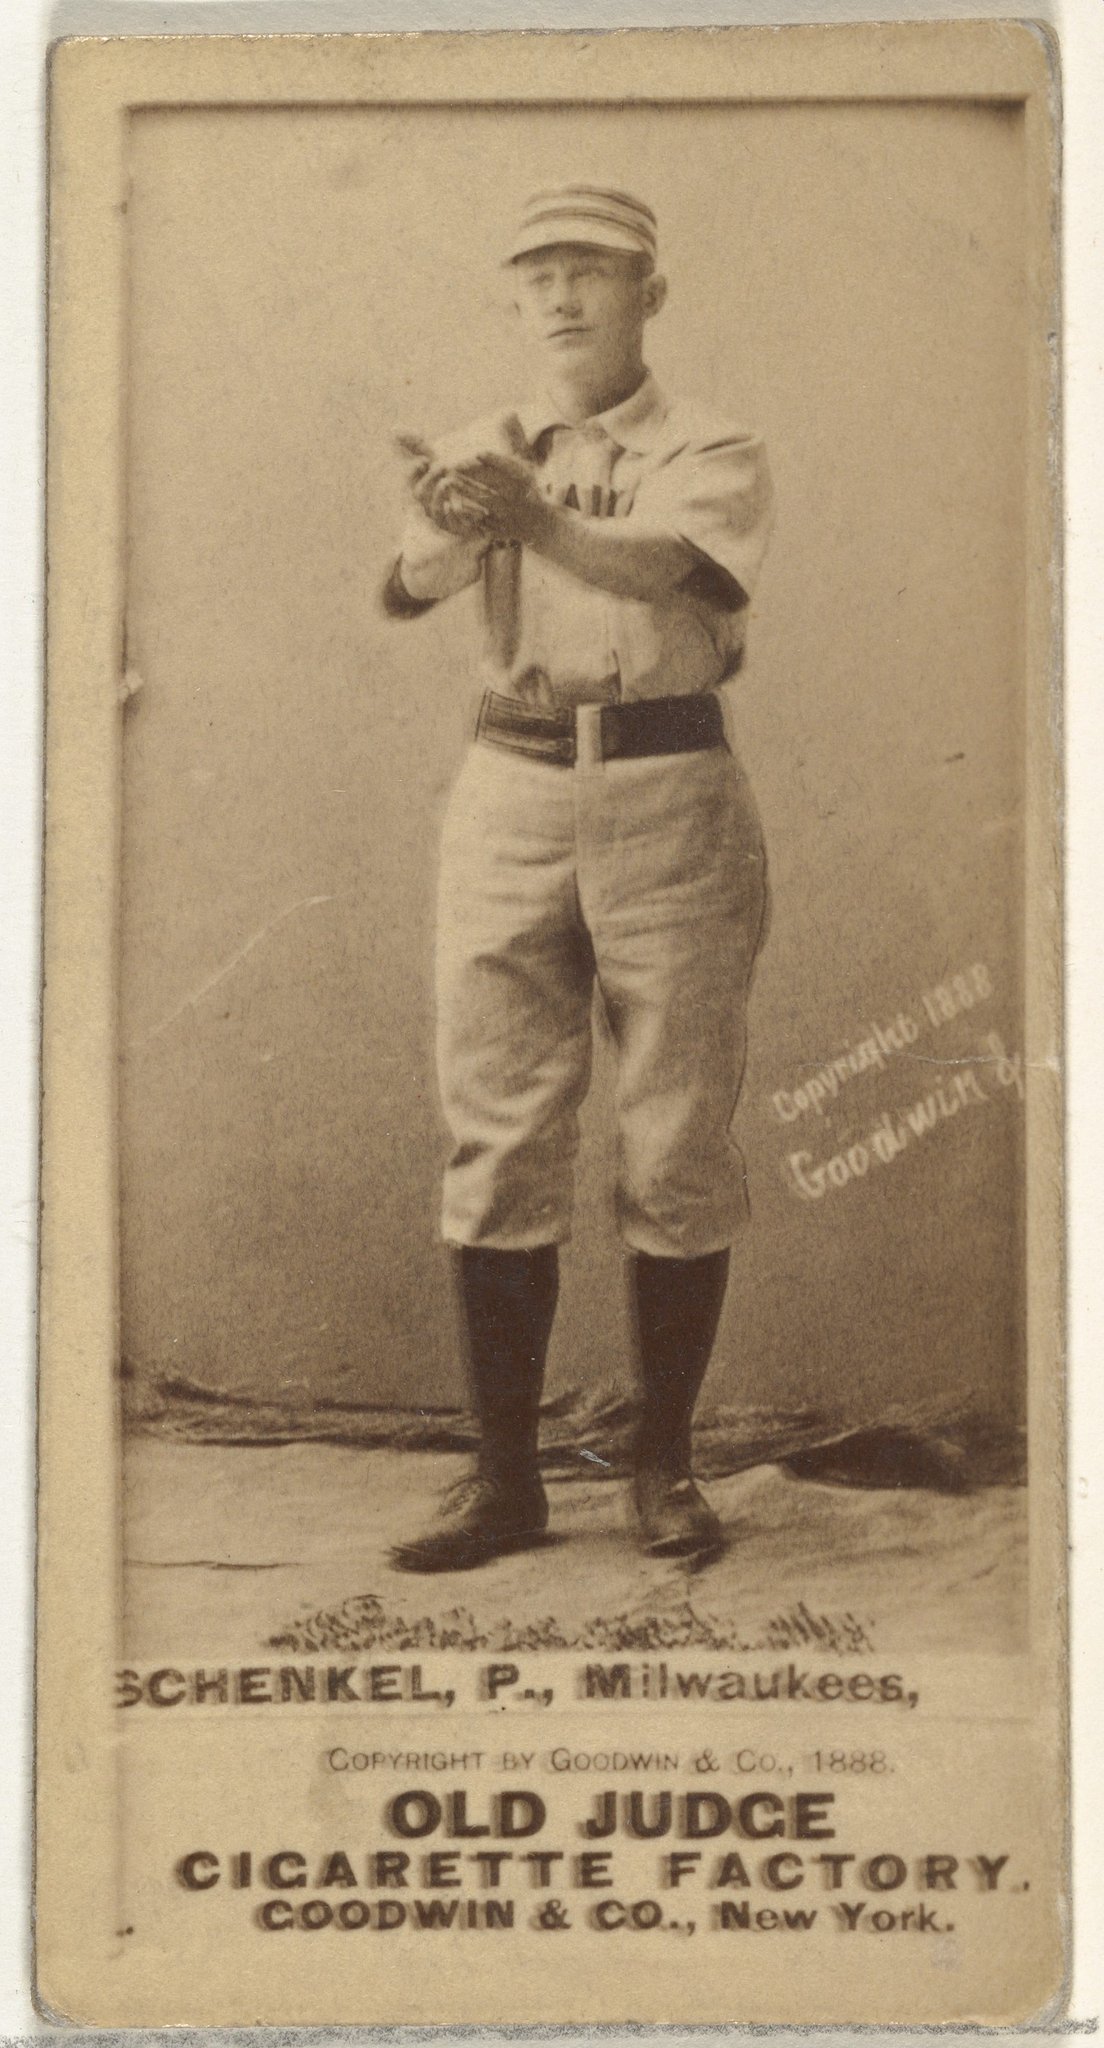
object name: baseball card, photograph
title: William Shenkel, Pitcher, Milwaukee, from the Old Judge series (N172) for Old Judge Cigarettes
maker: goodwin & company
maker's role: publisher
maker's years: 1850-1950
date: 1888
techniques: albumen silver print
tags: men,portraits,baseball,athletes